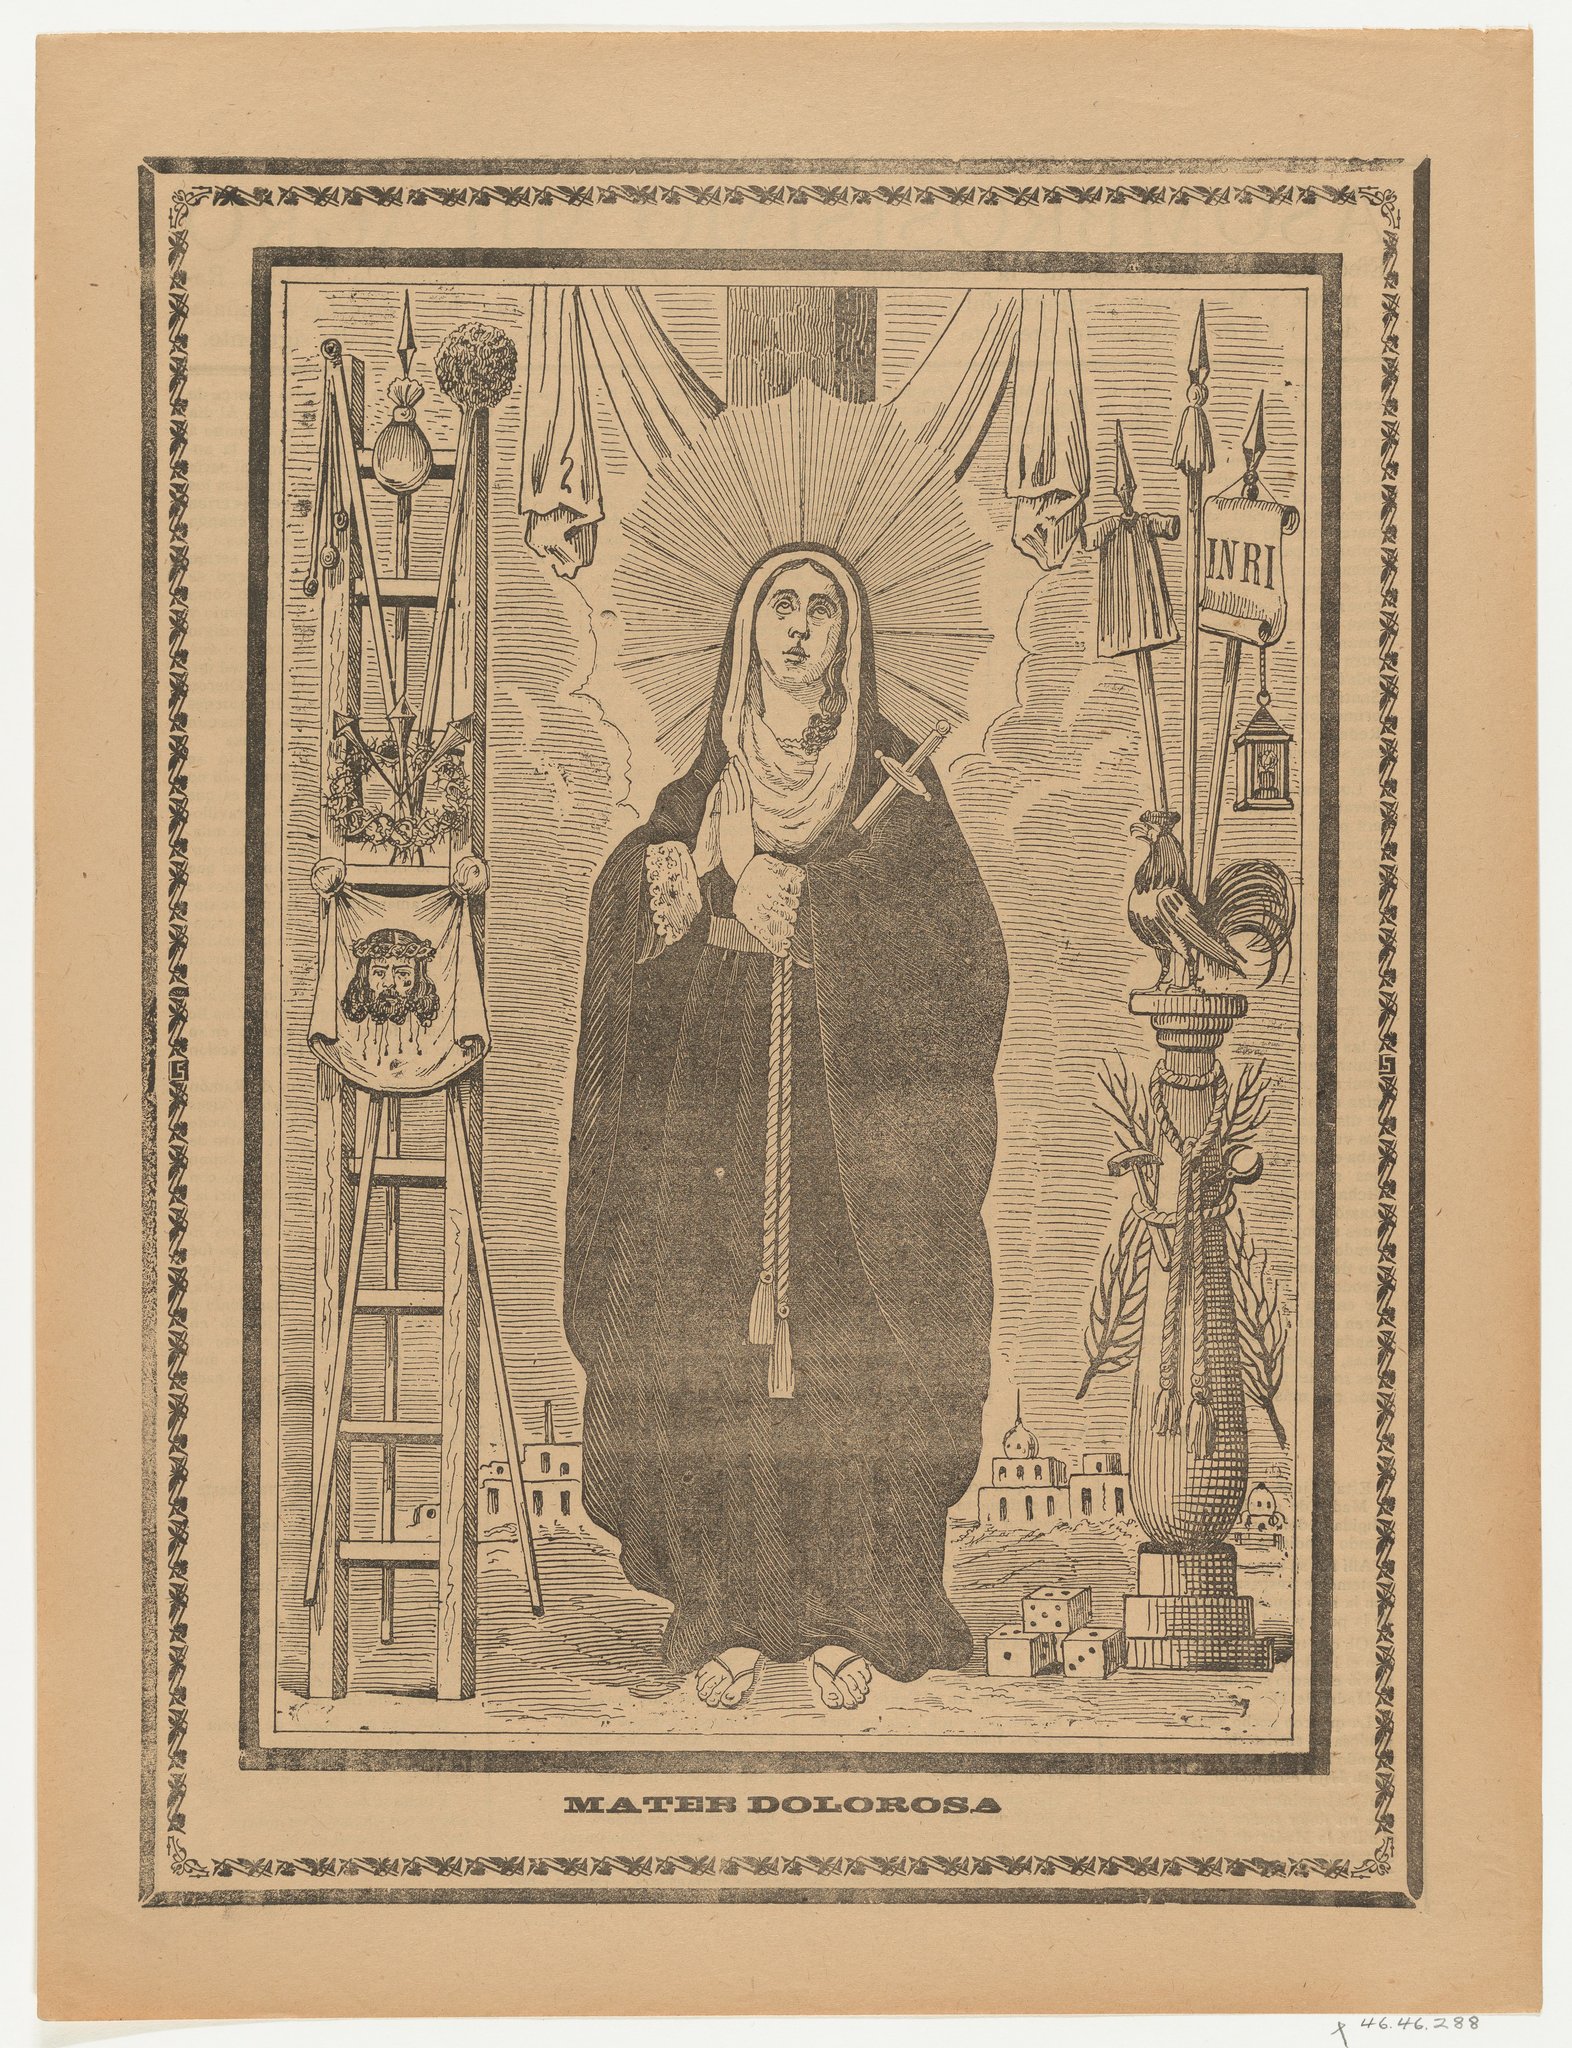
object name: print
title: Broadsheet with the Virgin of Sorrows, flanked by instruments on the Passion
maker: Anonymous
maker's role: artist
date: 1906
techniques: letterpress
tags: virgin mary,cross